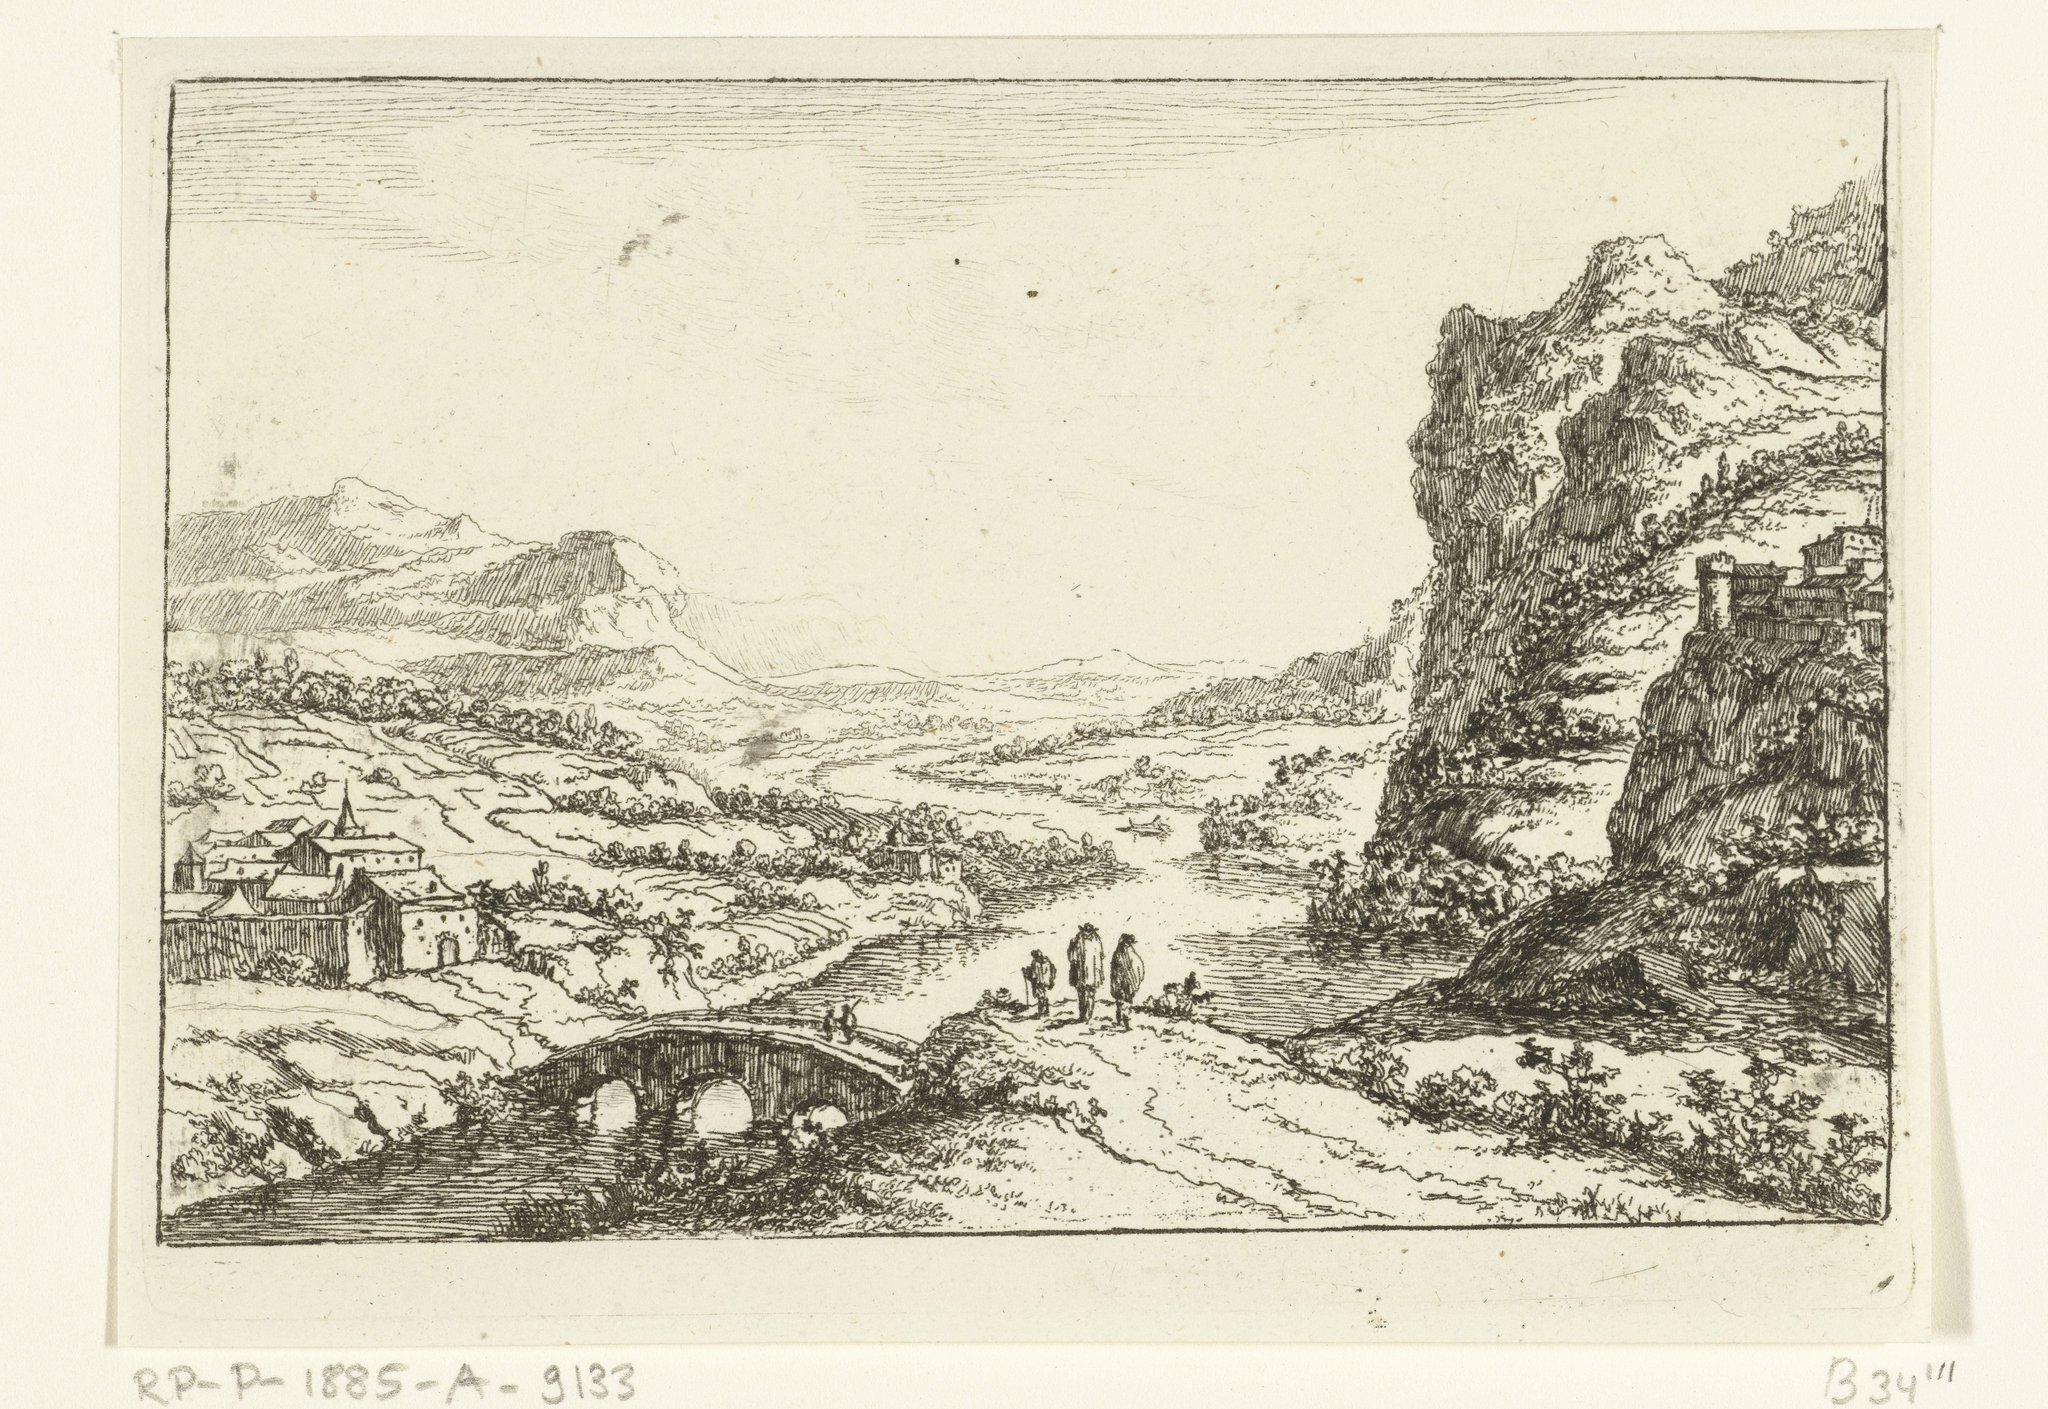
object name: print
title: Rivierlandschap met stenen brug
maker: jan van almeloveen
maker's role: draughtsman, print maker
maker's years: 1652-1683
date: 1662-1683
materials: paper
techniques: etching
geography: netherlands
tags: river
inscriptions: collector's mark: Lugt 2228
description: Als boekillustratie gebruikt in: Spiegel der natuur en school der teekenkunde, Amsterdam, J.S. van Esveldt-Holtrop, c. 1780 (RMAB 318 G 10)